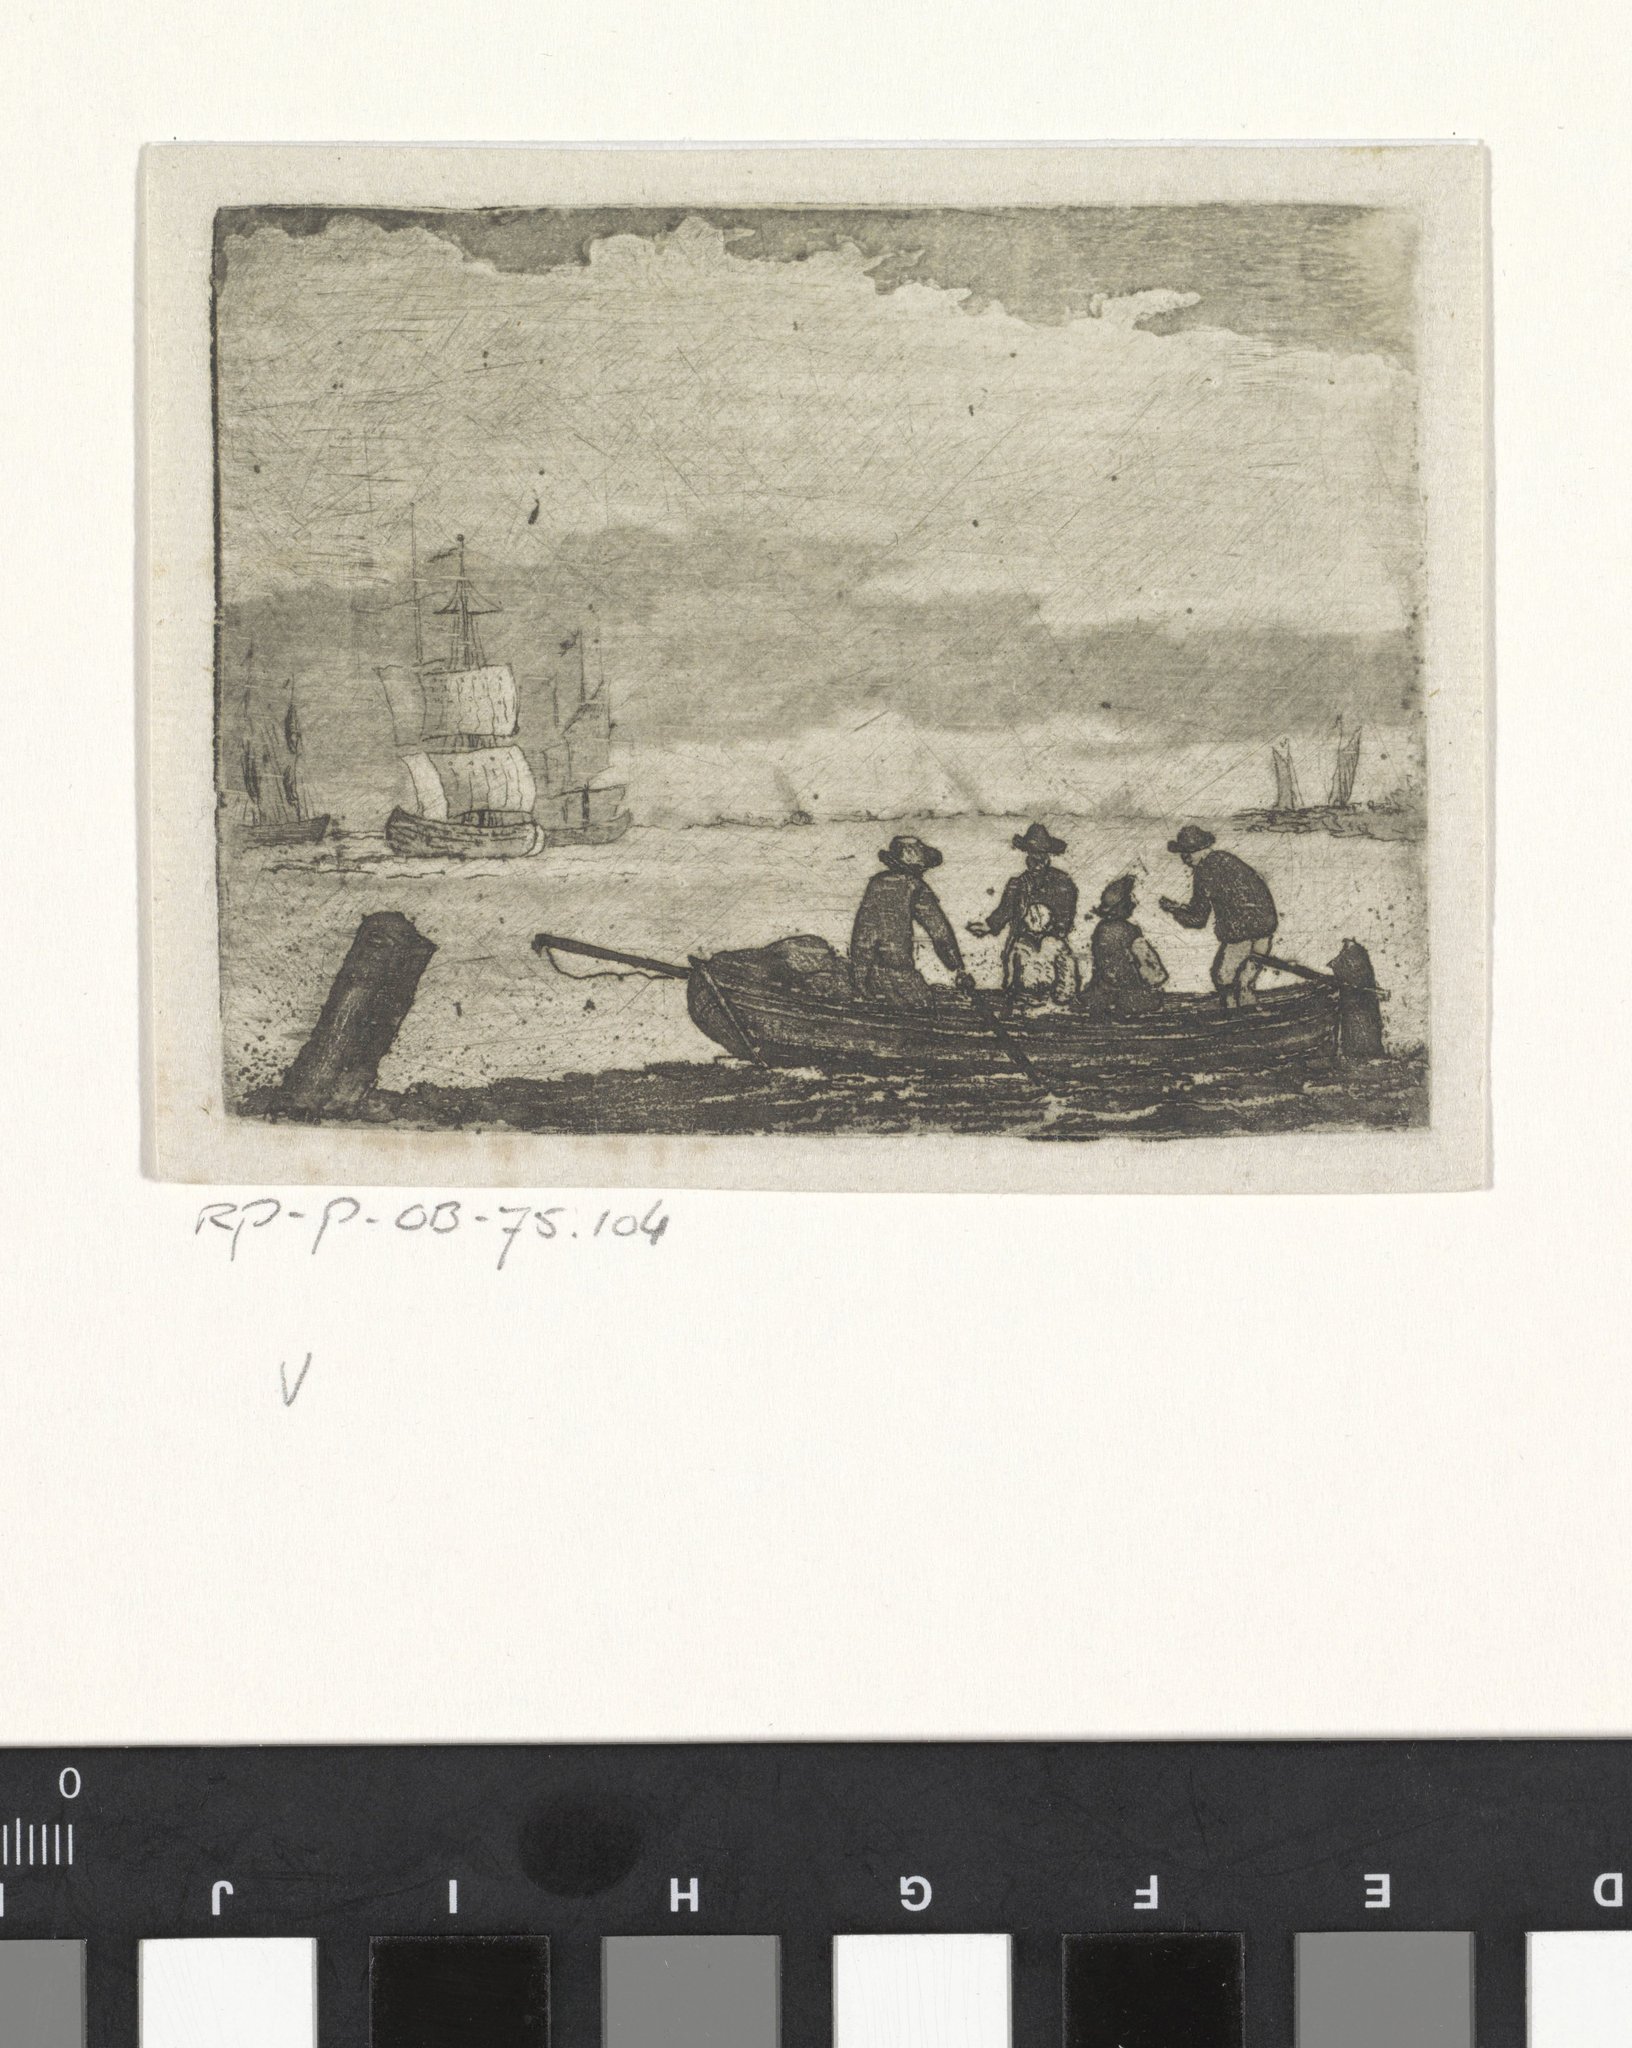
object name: print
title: Zeegezicht met een sloep op de voorgrond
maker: Anonymous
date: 1600-1700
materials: paper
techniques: aquatint, etching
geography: netherlands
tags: rowing-boat, canoe, etc.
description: Zeegezicht met een sloep op de voorgrond. In de sloep zitten vijf figuren.